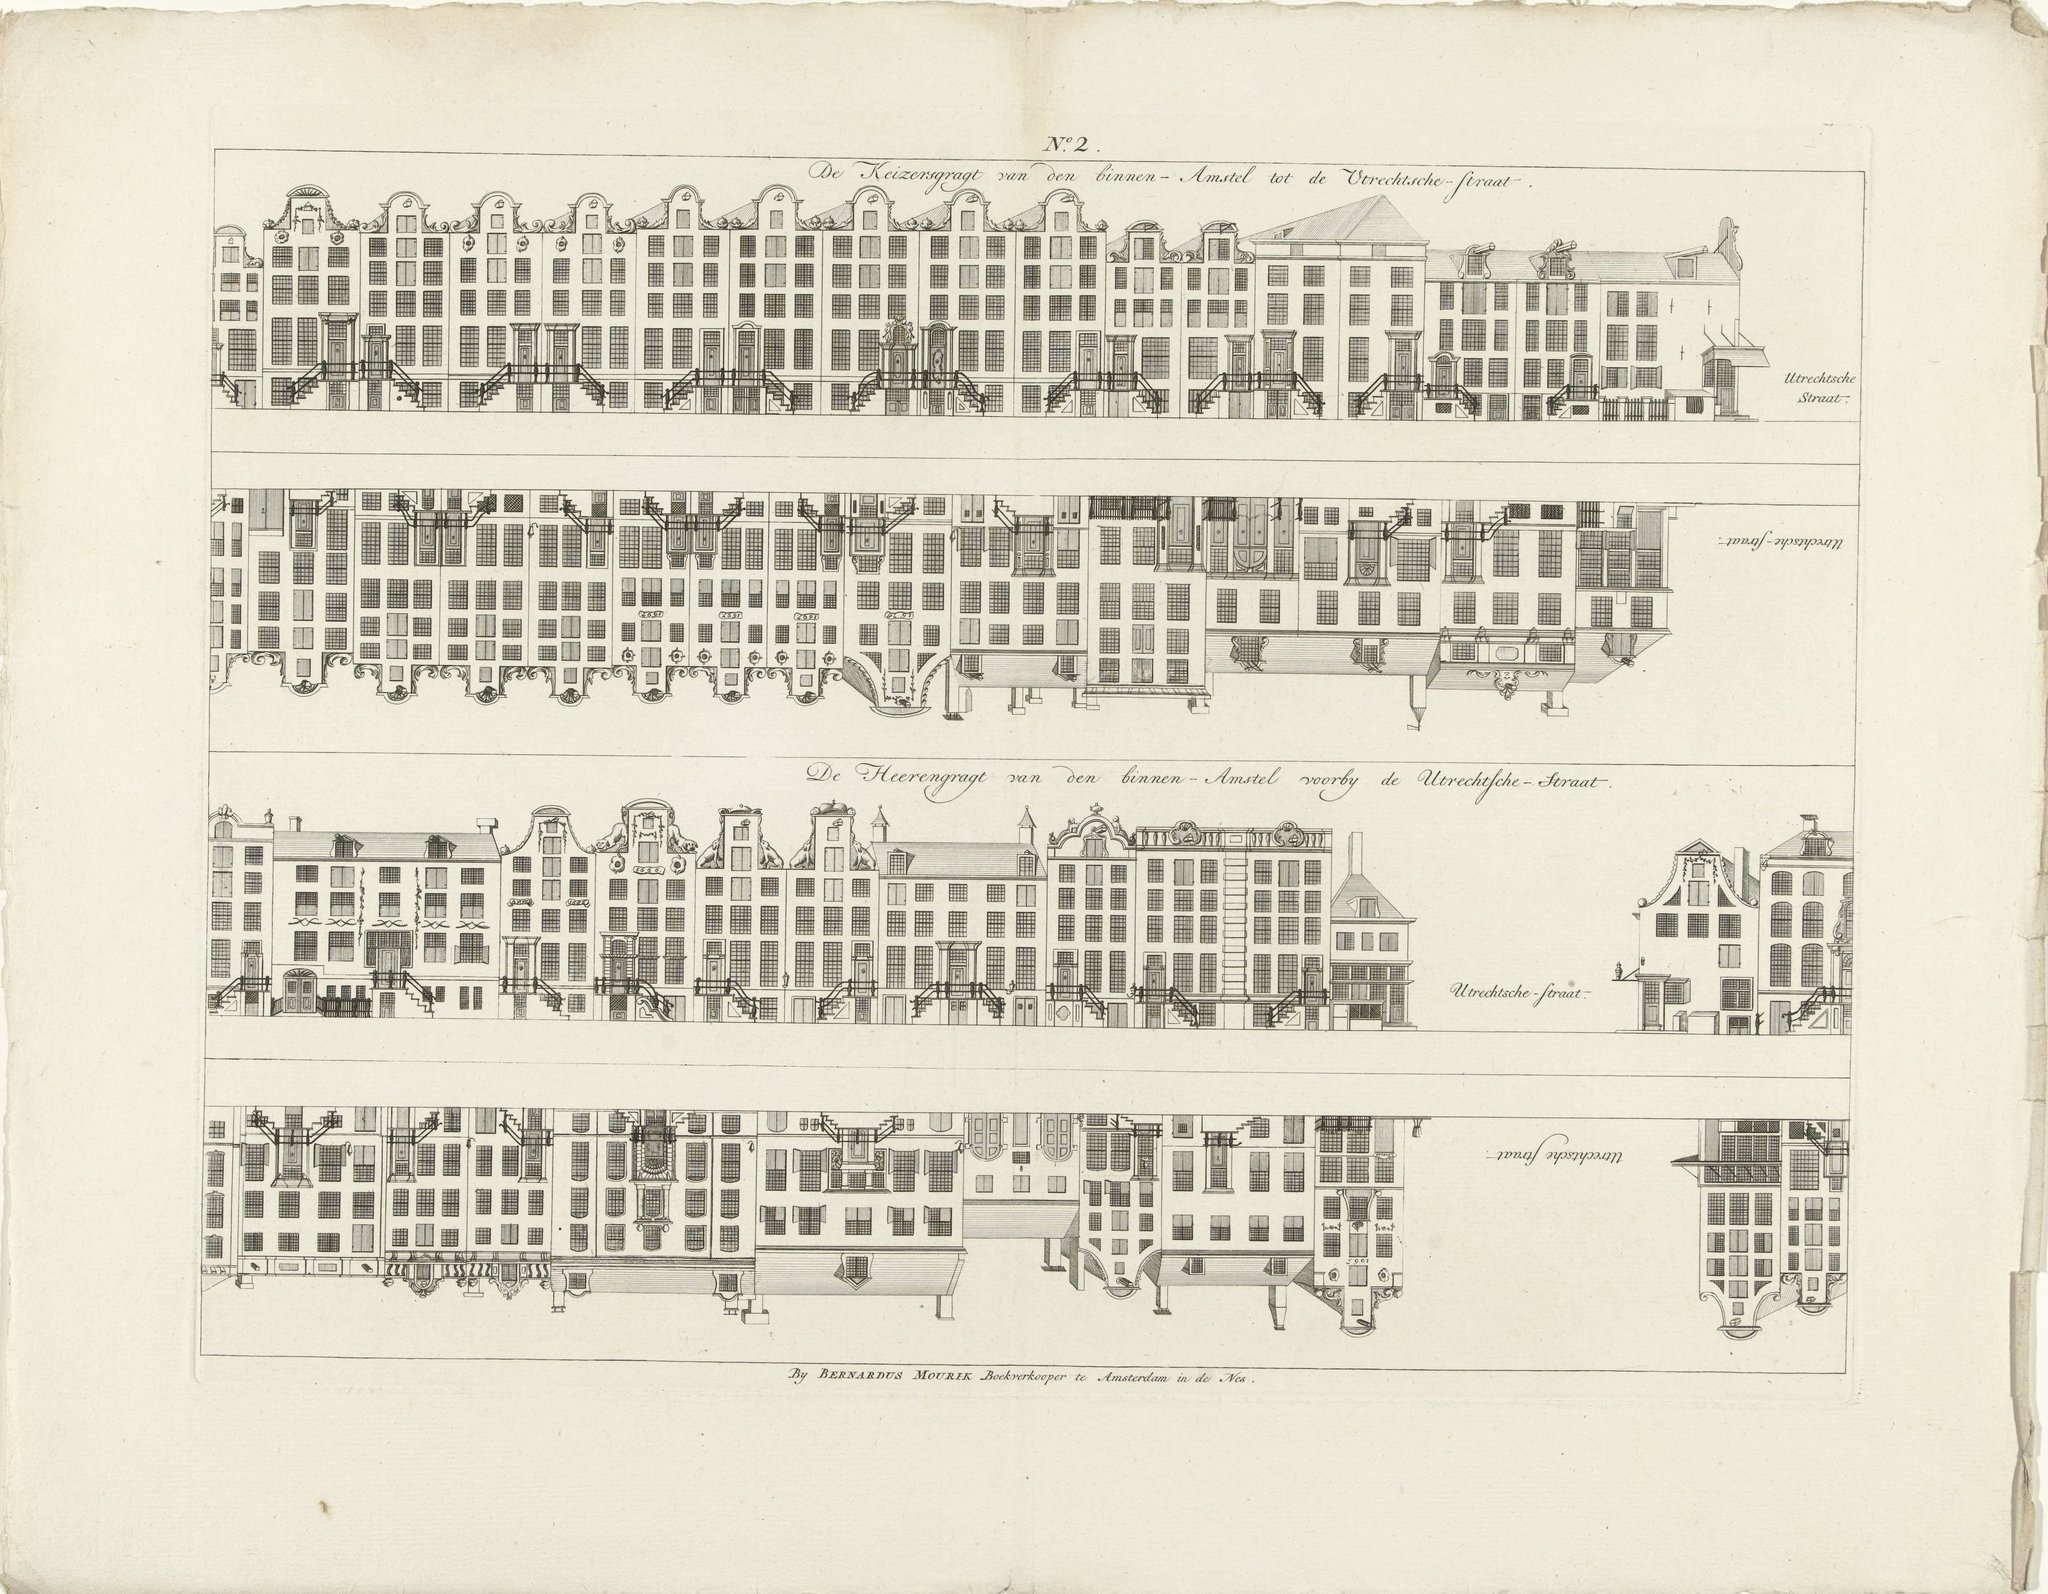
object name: print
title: Verzameling van alle De Huizen en Gebouwen langs de Keizers en Heeren-Grachten der Stad Amsterdam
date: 1768-1771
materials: paper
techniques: etching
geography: amsterdam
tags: front façade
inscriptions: collector's mark: Lugt 2228, collector's mark: Lugt 2233